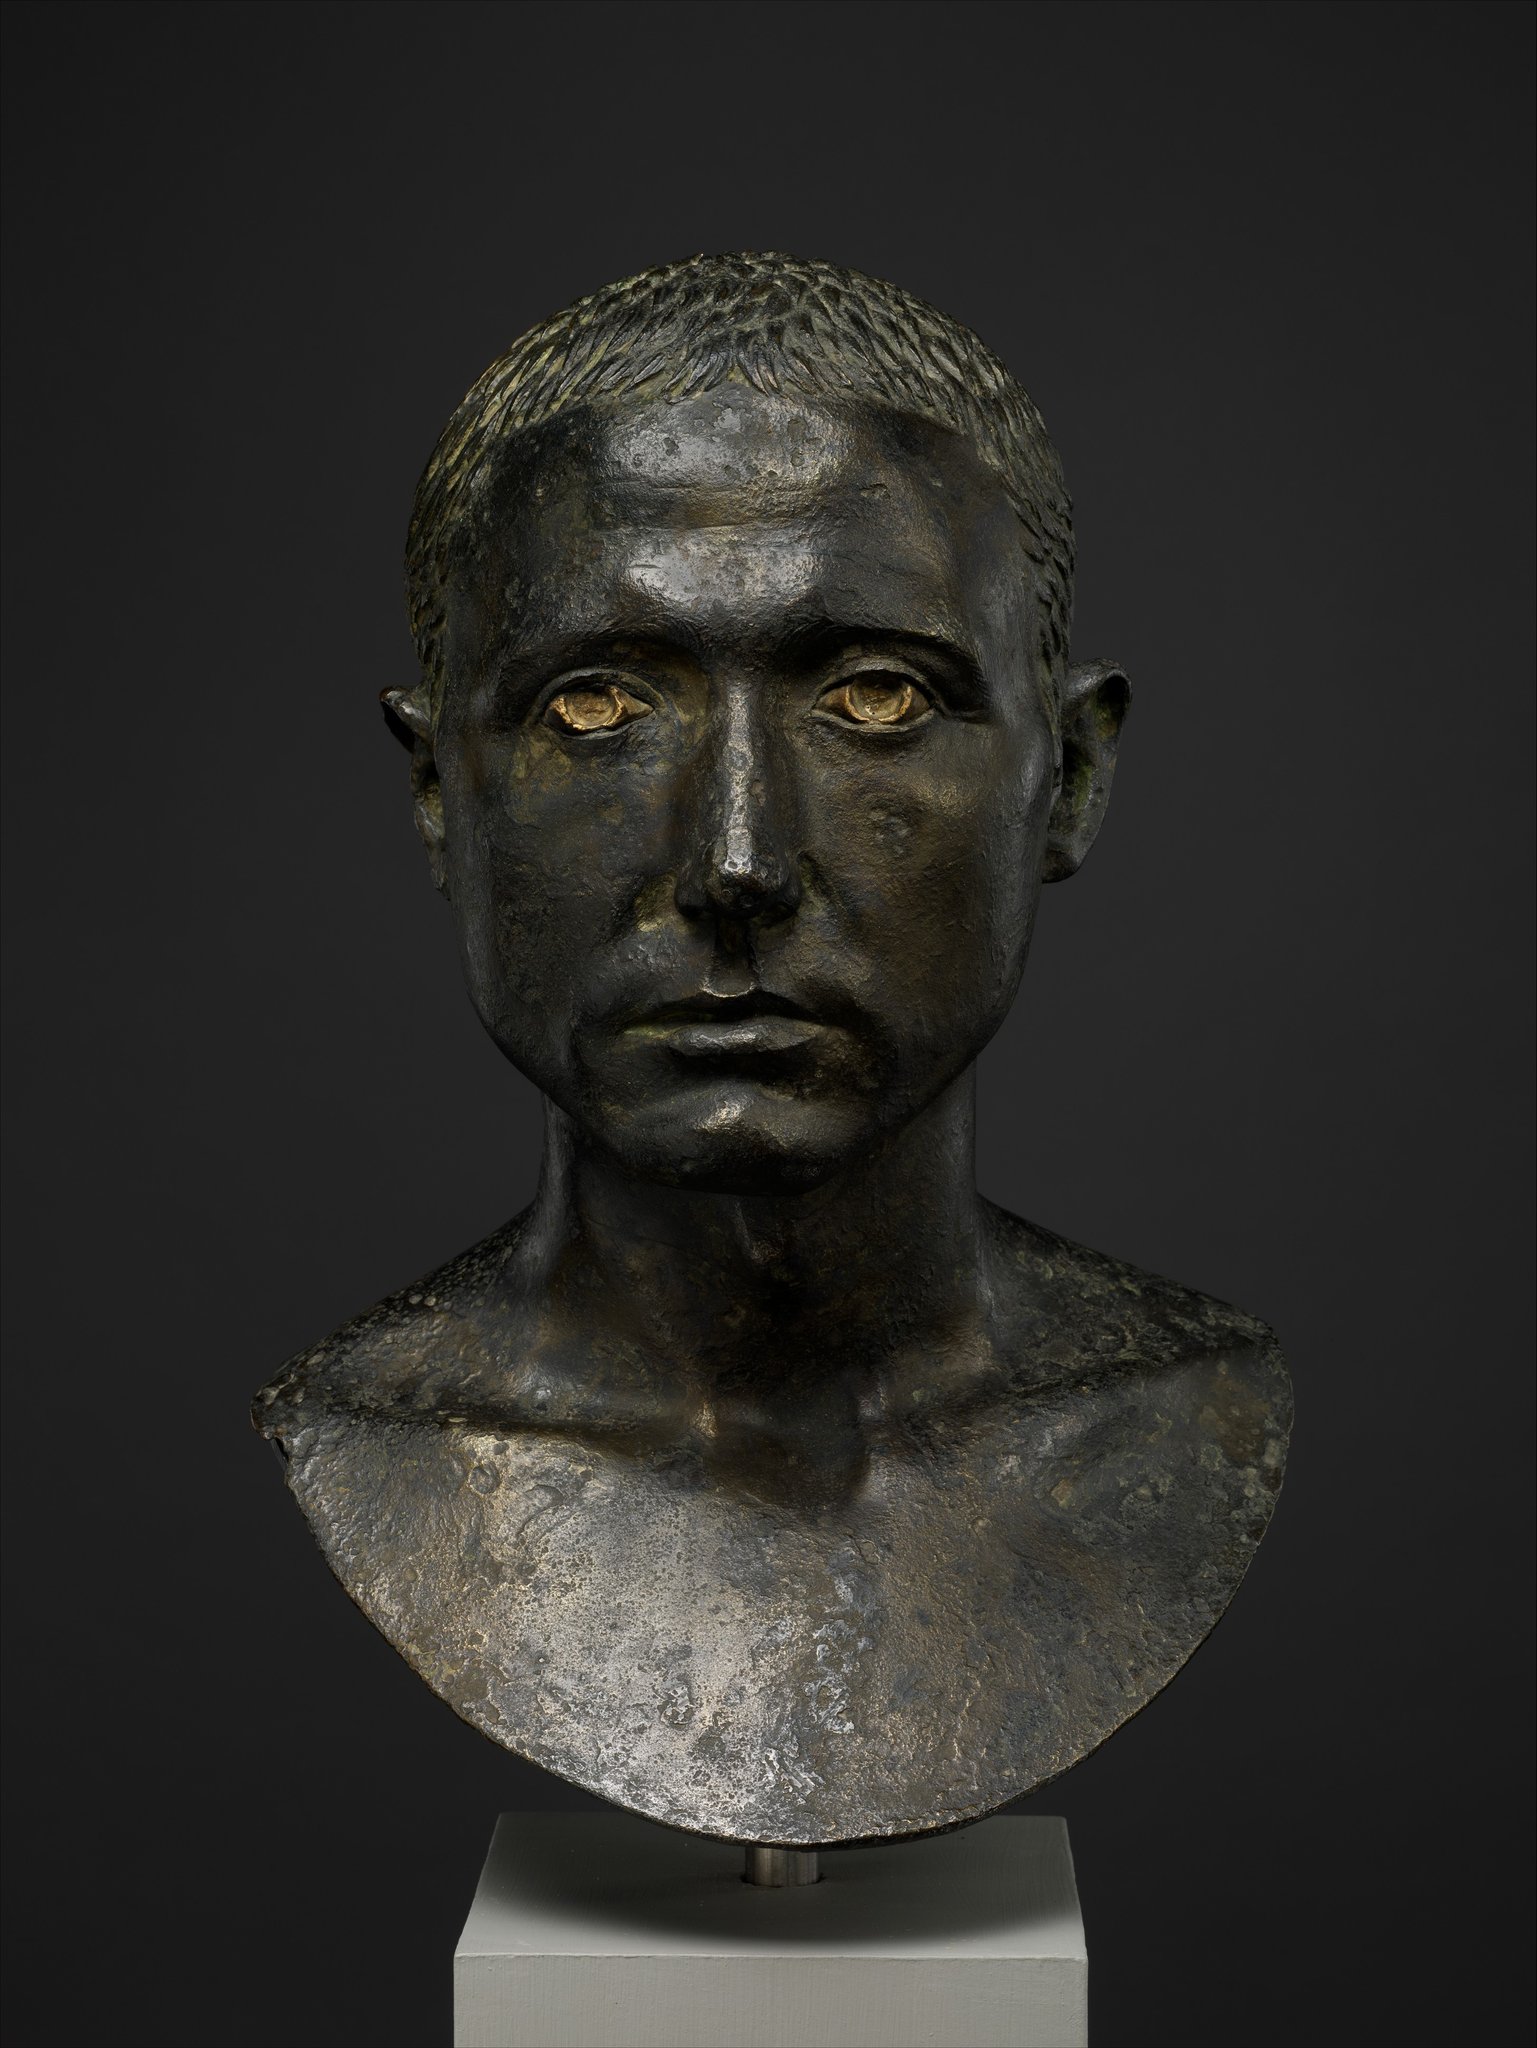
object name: portrait bust of a man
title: Bronze portrait bust of a man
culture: roman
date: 50 BCE-54 CE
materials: bronze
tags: men,portraits